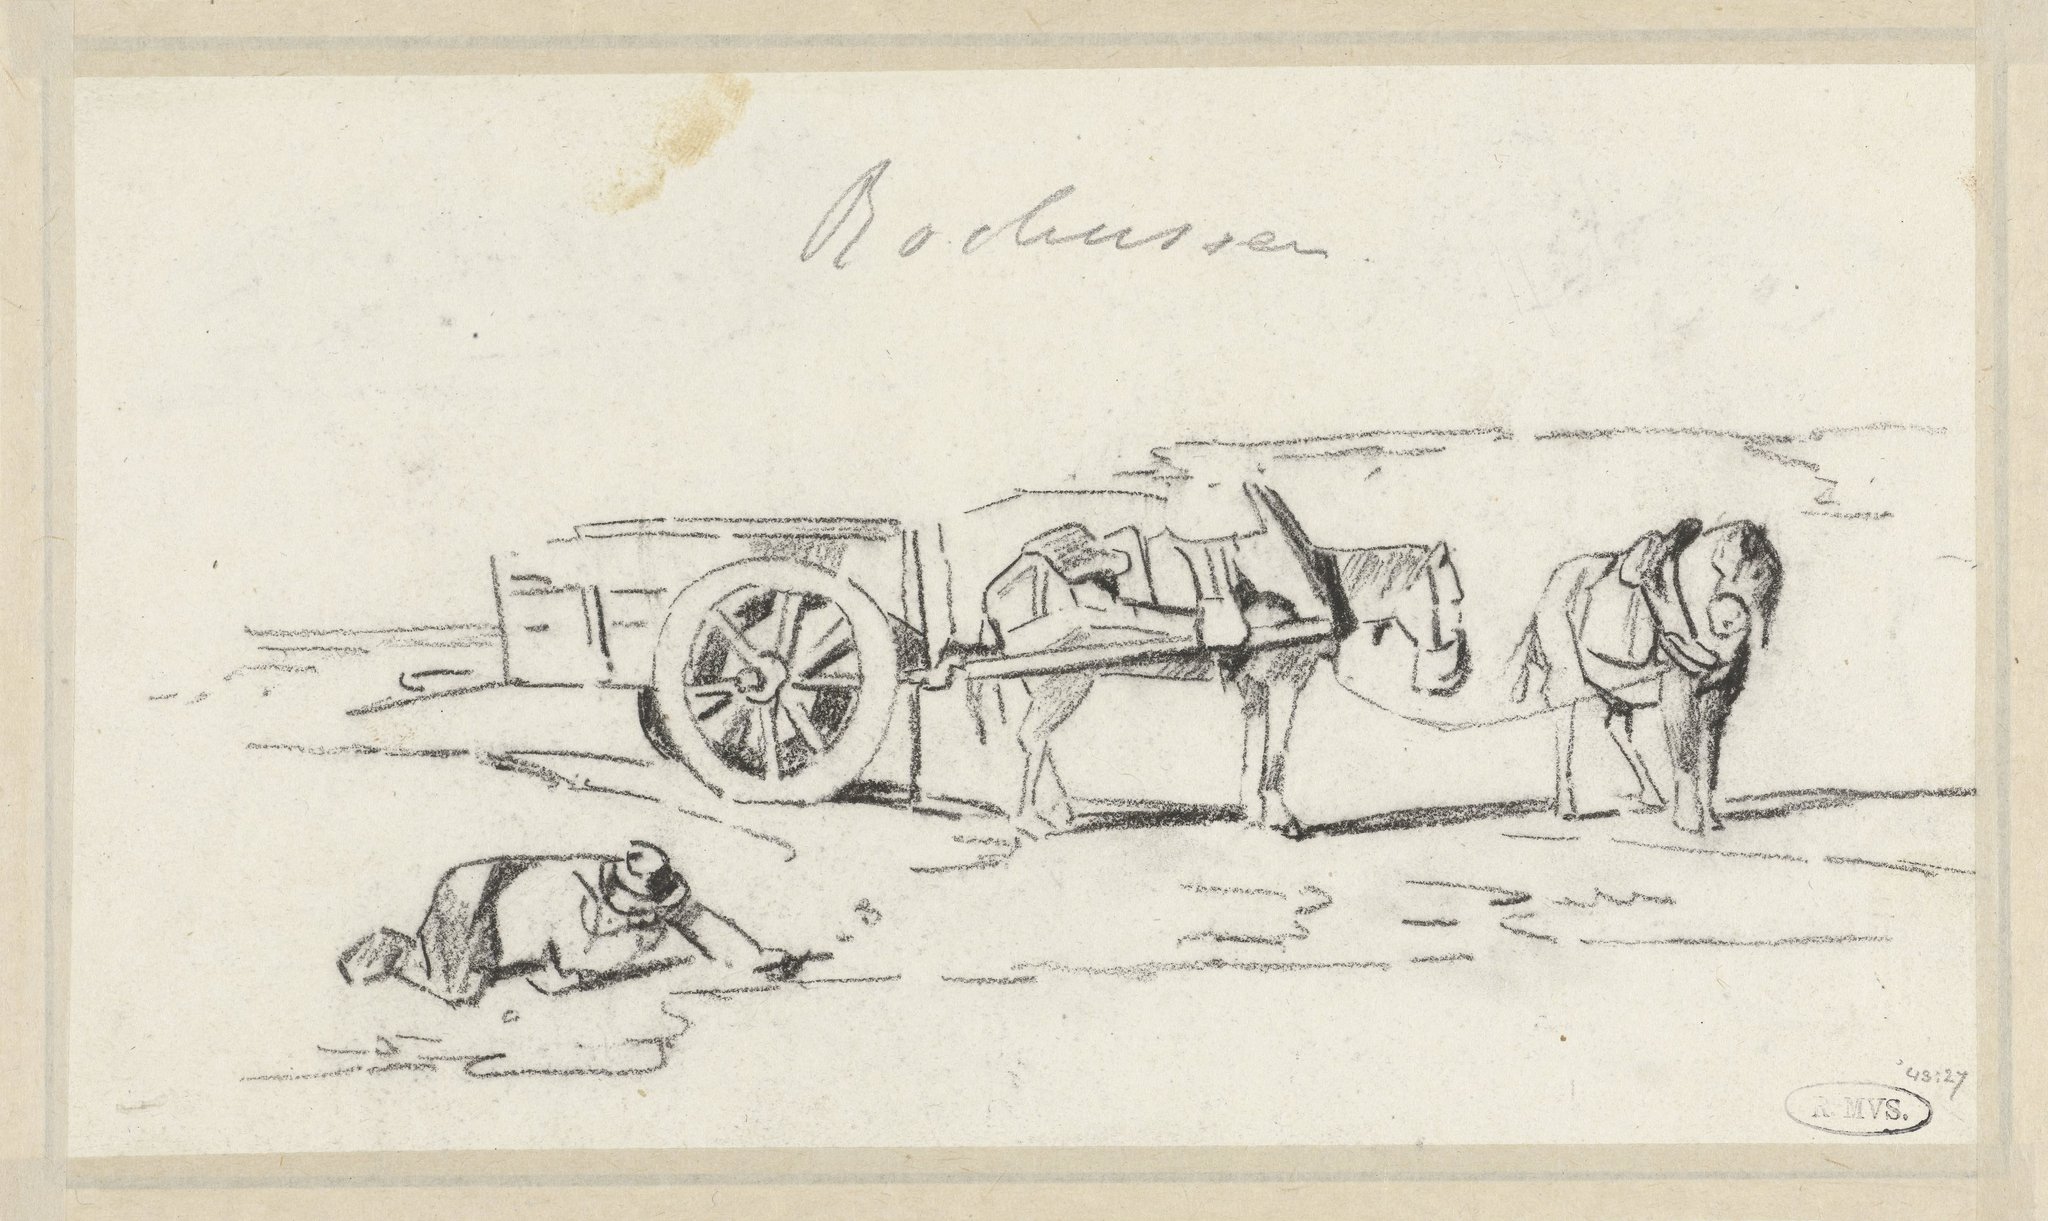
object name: drawing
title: Schelpenvisser geknield liggend aan de oeverrand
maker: Anonymous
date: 1800-1900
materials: paper, pencil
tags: four-wheeled vehicle drawn by one animal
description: Schelpenvisser geknield liggend aan de oeverrand. Achter hem een wagen met twee paarden. Omtrektekening van het onderste tafereel van de voorzijde